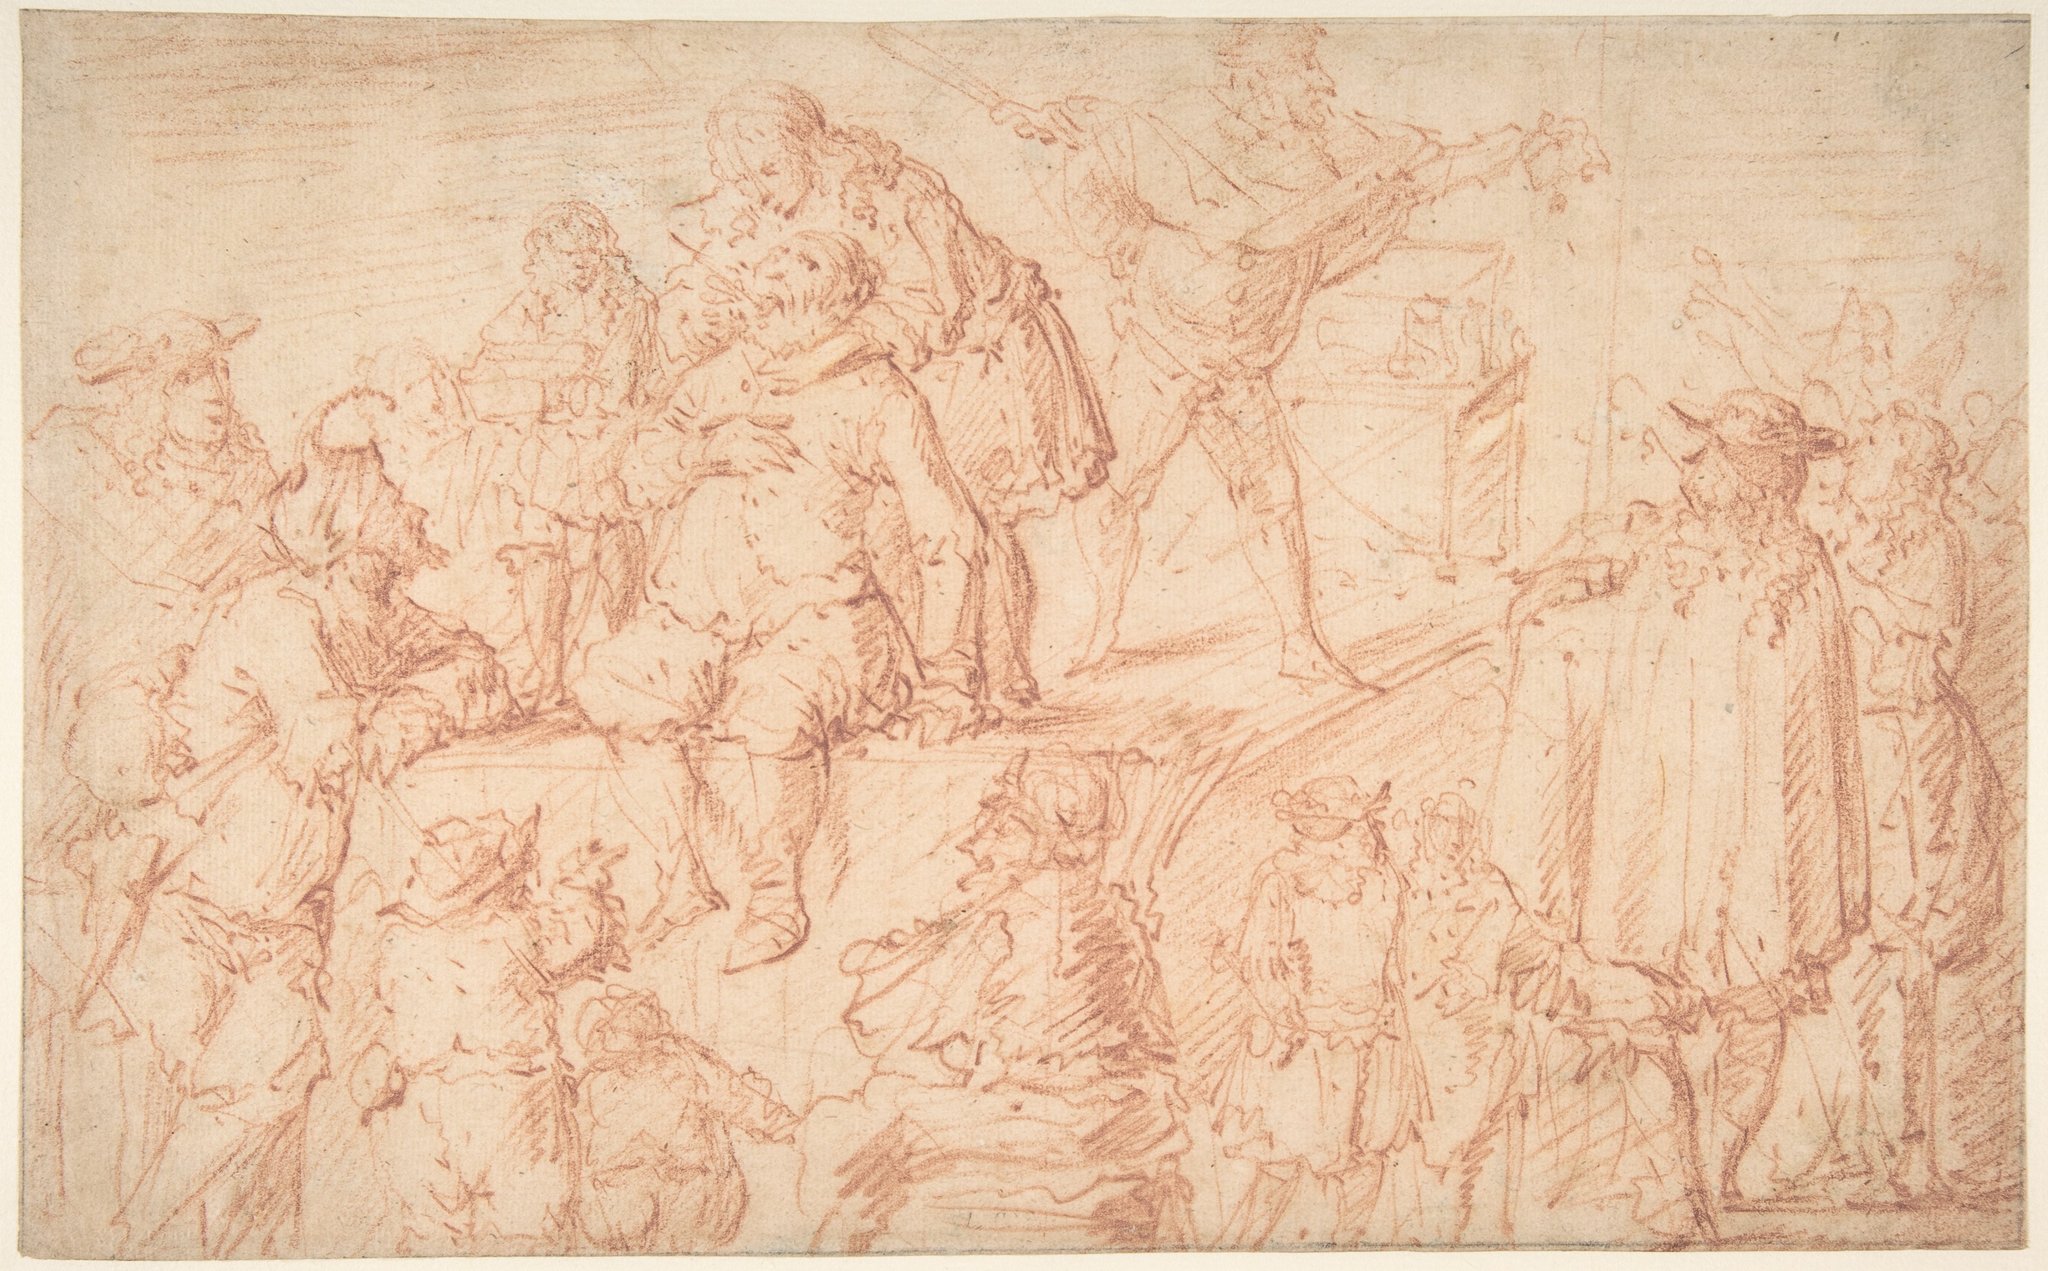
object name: drawing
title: Italian Comedians Performing in a Public Square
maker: jacob matthias weyer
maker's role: artist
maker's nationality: german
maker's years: 1620-1691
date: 1635-1691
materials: chalk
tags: performance,men,women